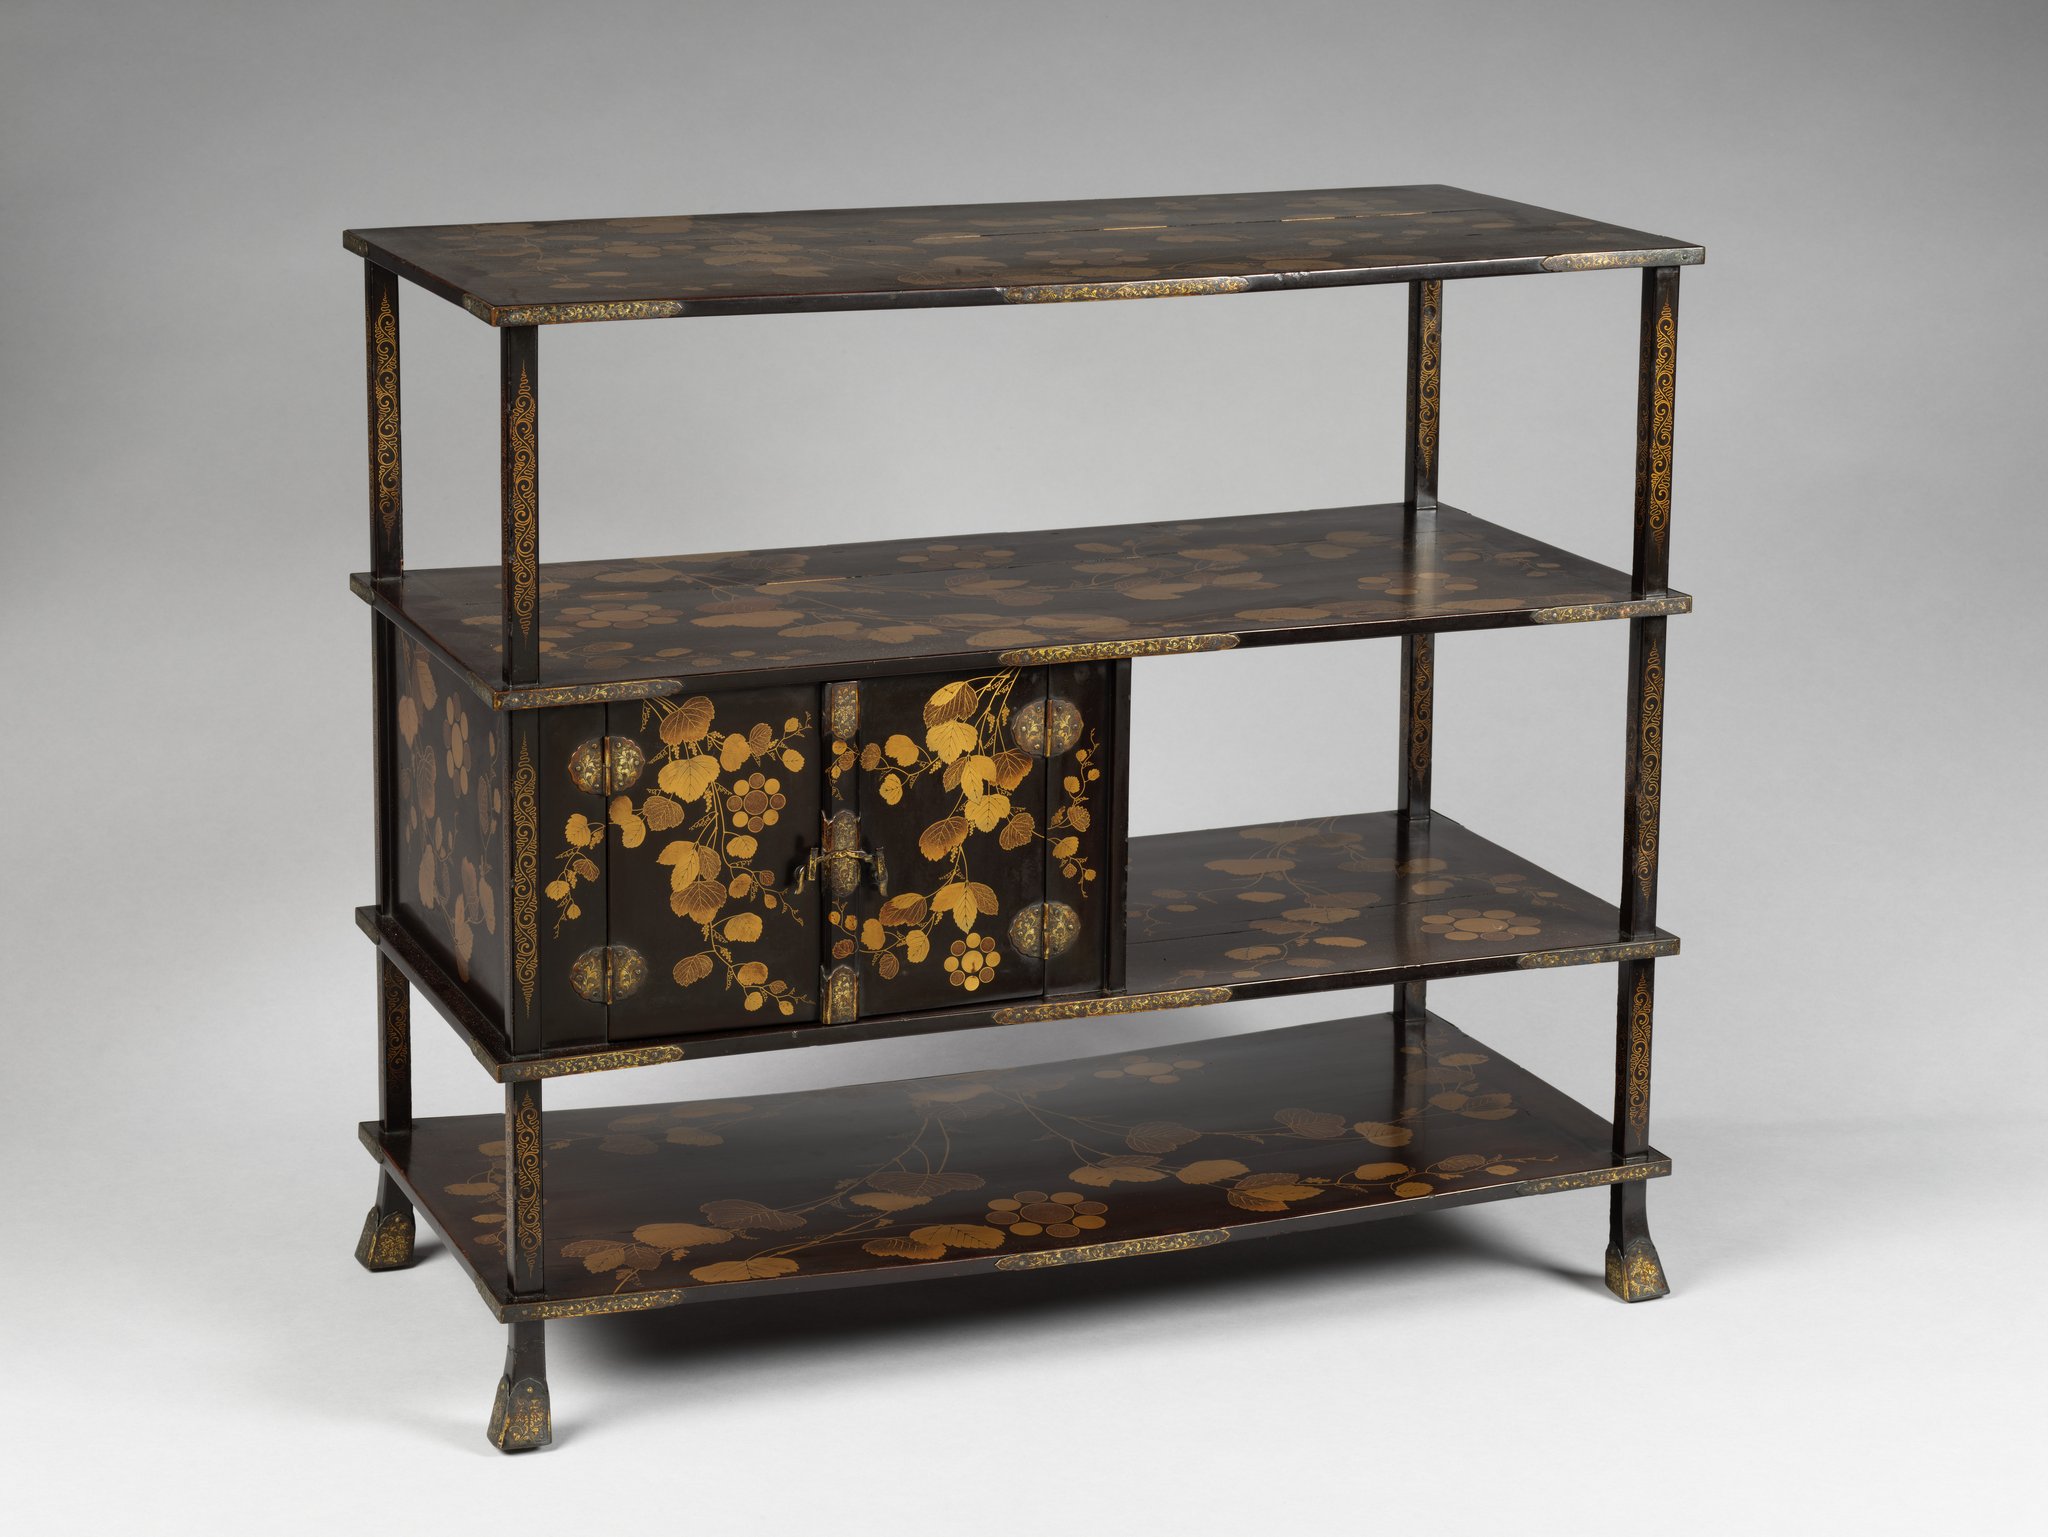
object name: shelf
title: Shelf for Cosmetic Boxes (Kurodana) with Wild Grapevine and Family Crest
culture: japanese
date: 1601-1650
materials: gold, silver, wood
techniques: hiramakie, lacquer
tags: leaves